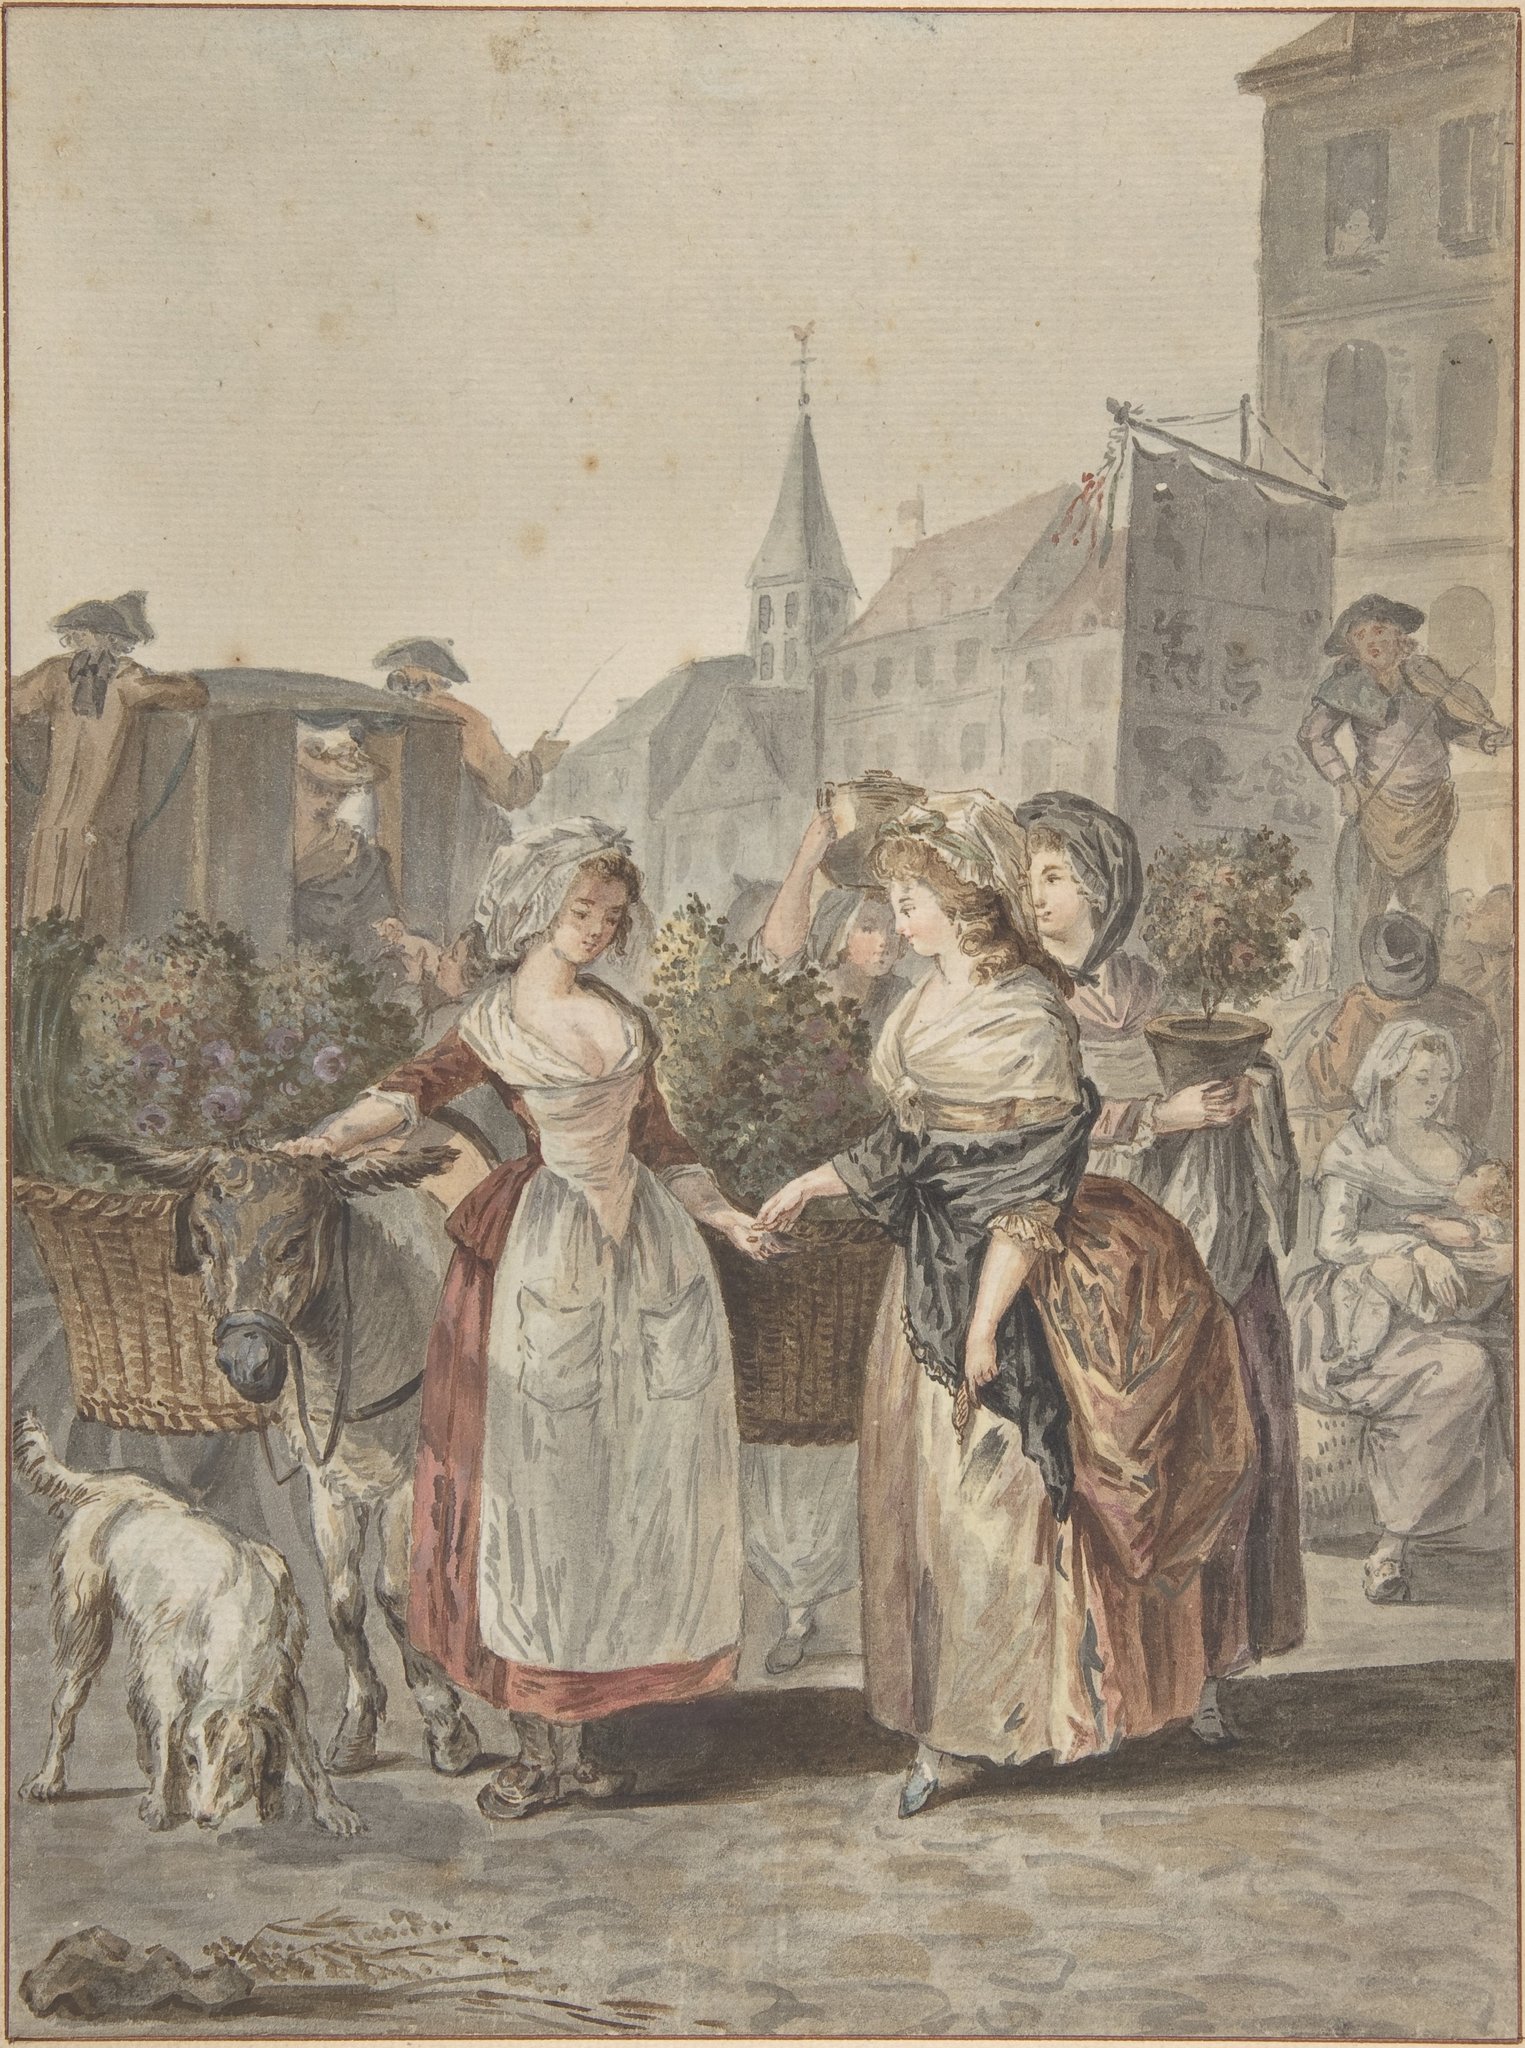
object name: drawing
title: The Flower Girl (La Petite Marchande de Fleurs)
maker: antoine louis françois sergent marceau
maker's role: artist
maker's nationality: french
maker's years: 1751-1847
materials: watercolor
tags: girls,dogs,donkeys,flowers,musicians